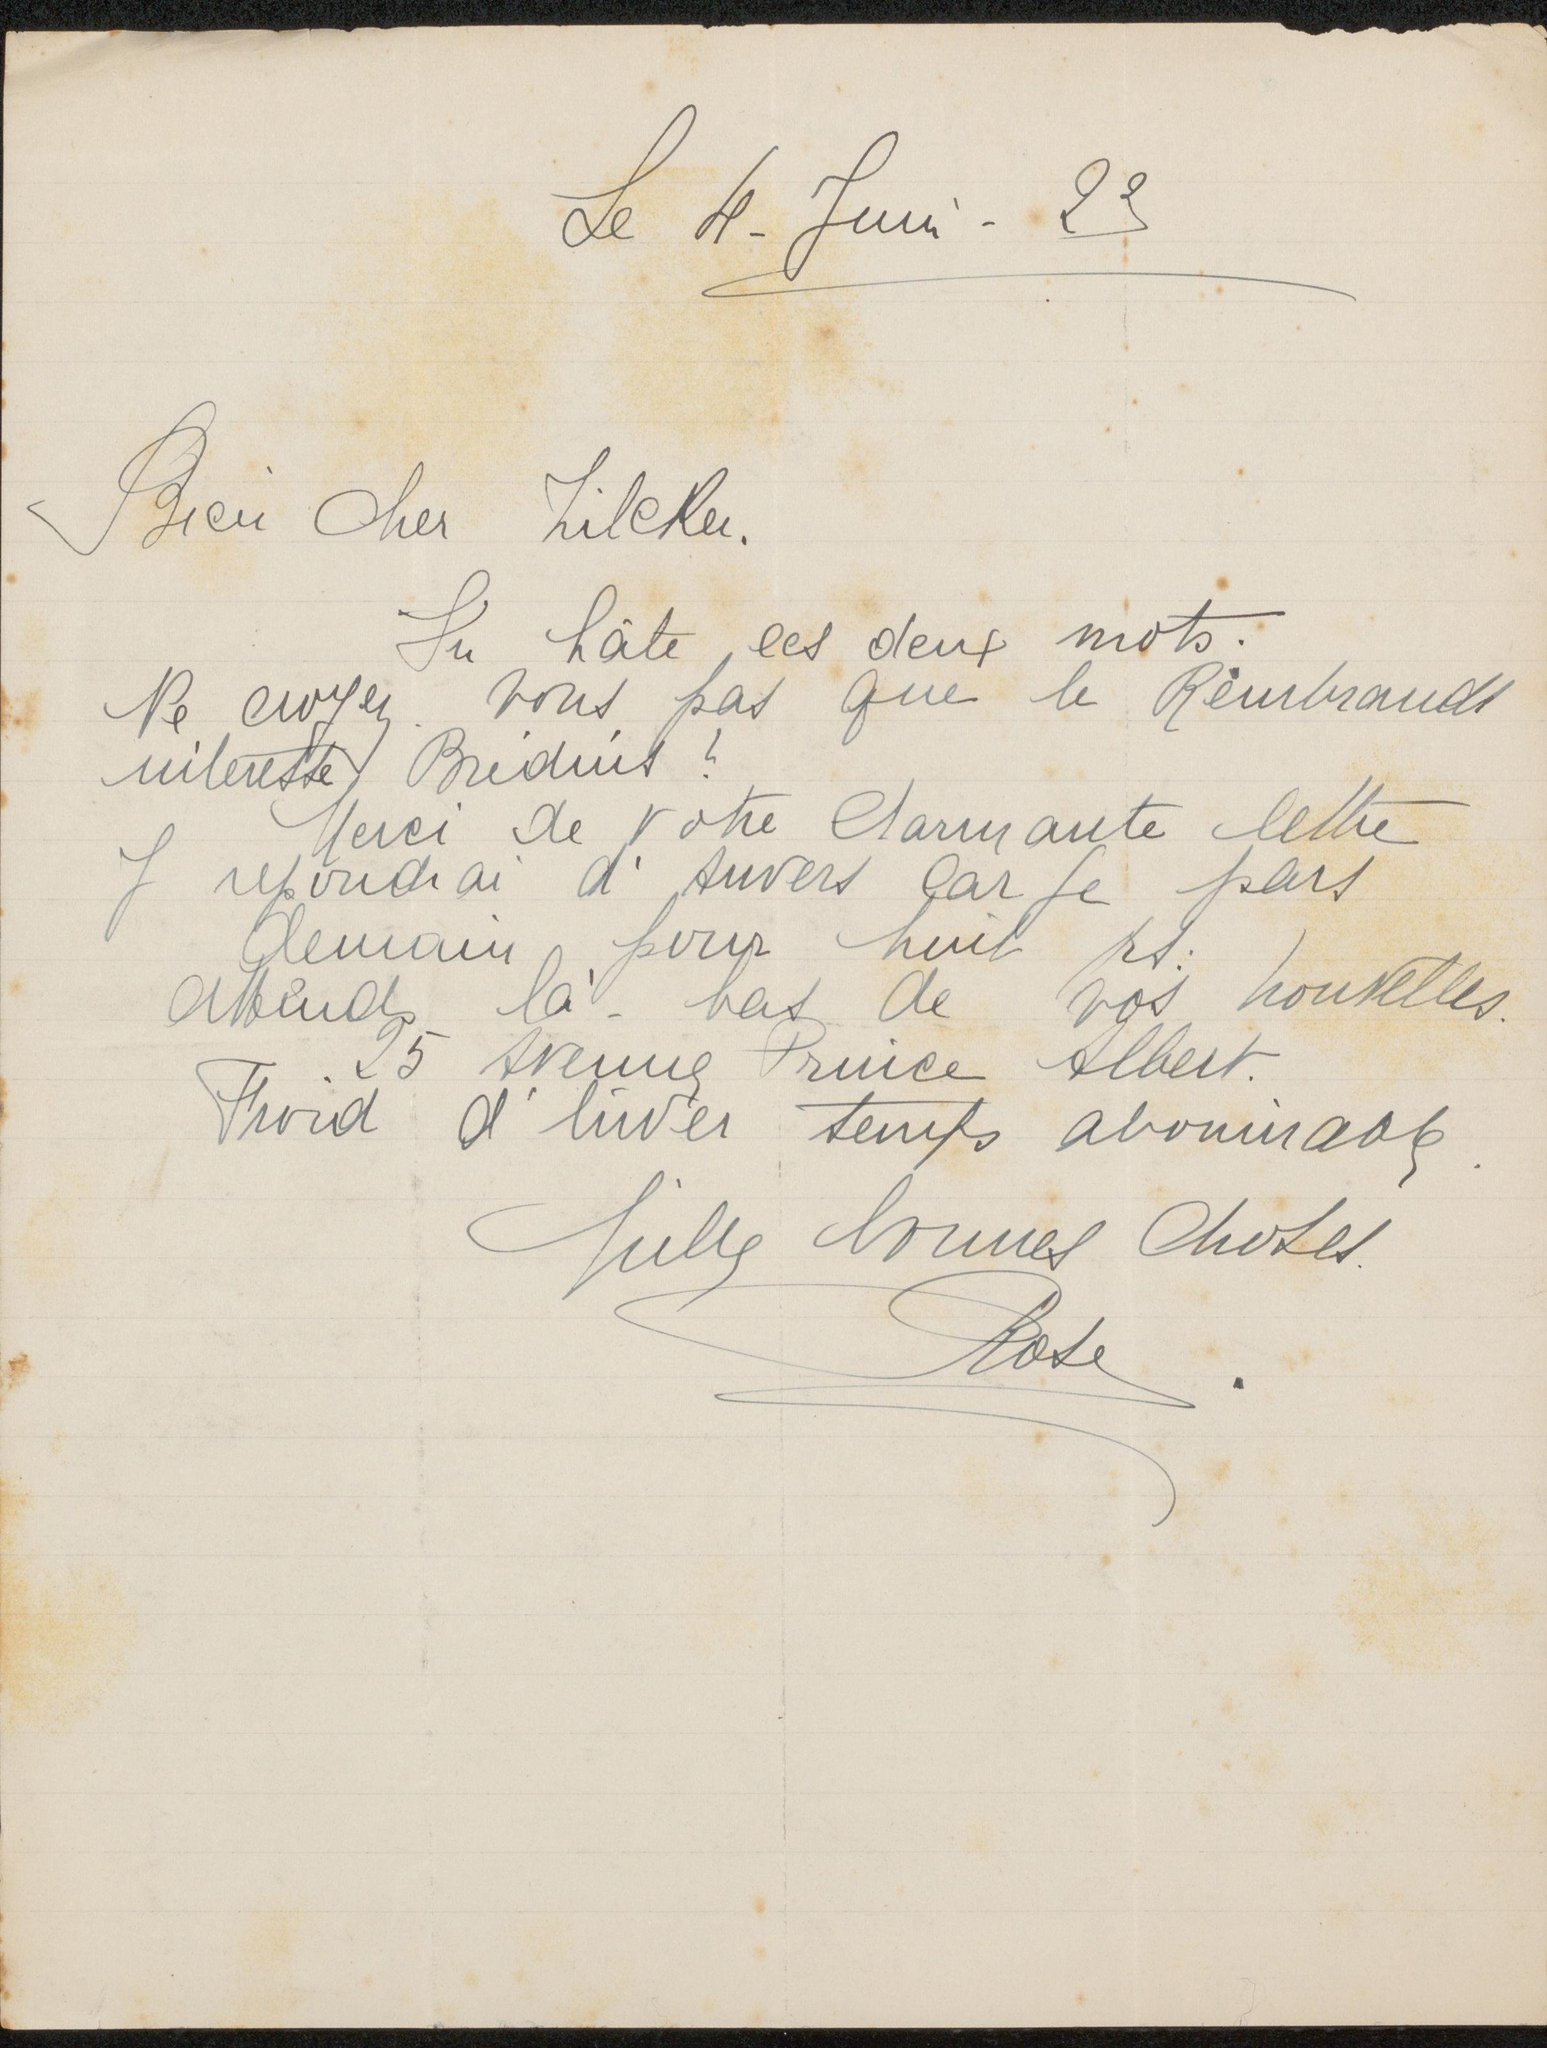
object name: letter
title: Brief aan Philip Zilcken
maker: rose imel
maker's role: draughtsman, painter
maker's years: 1901-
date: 1923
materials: ink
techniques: pen, writing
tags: leiden, painter, print maker, draughtsman, rembrandt van rijn, amsterdam, abraham bredius, philip zilcken, antwerp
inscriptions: collector's mark: ‘RPK’